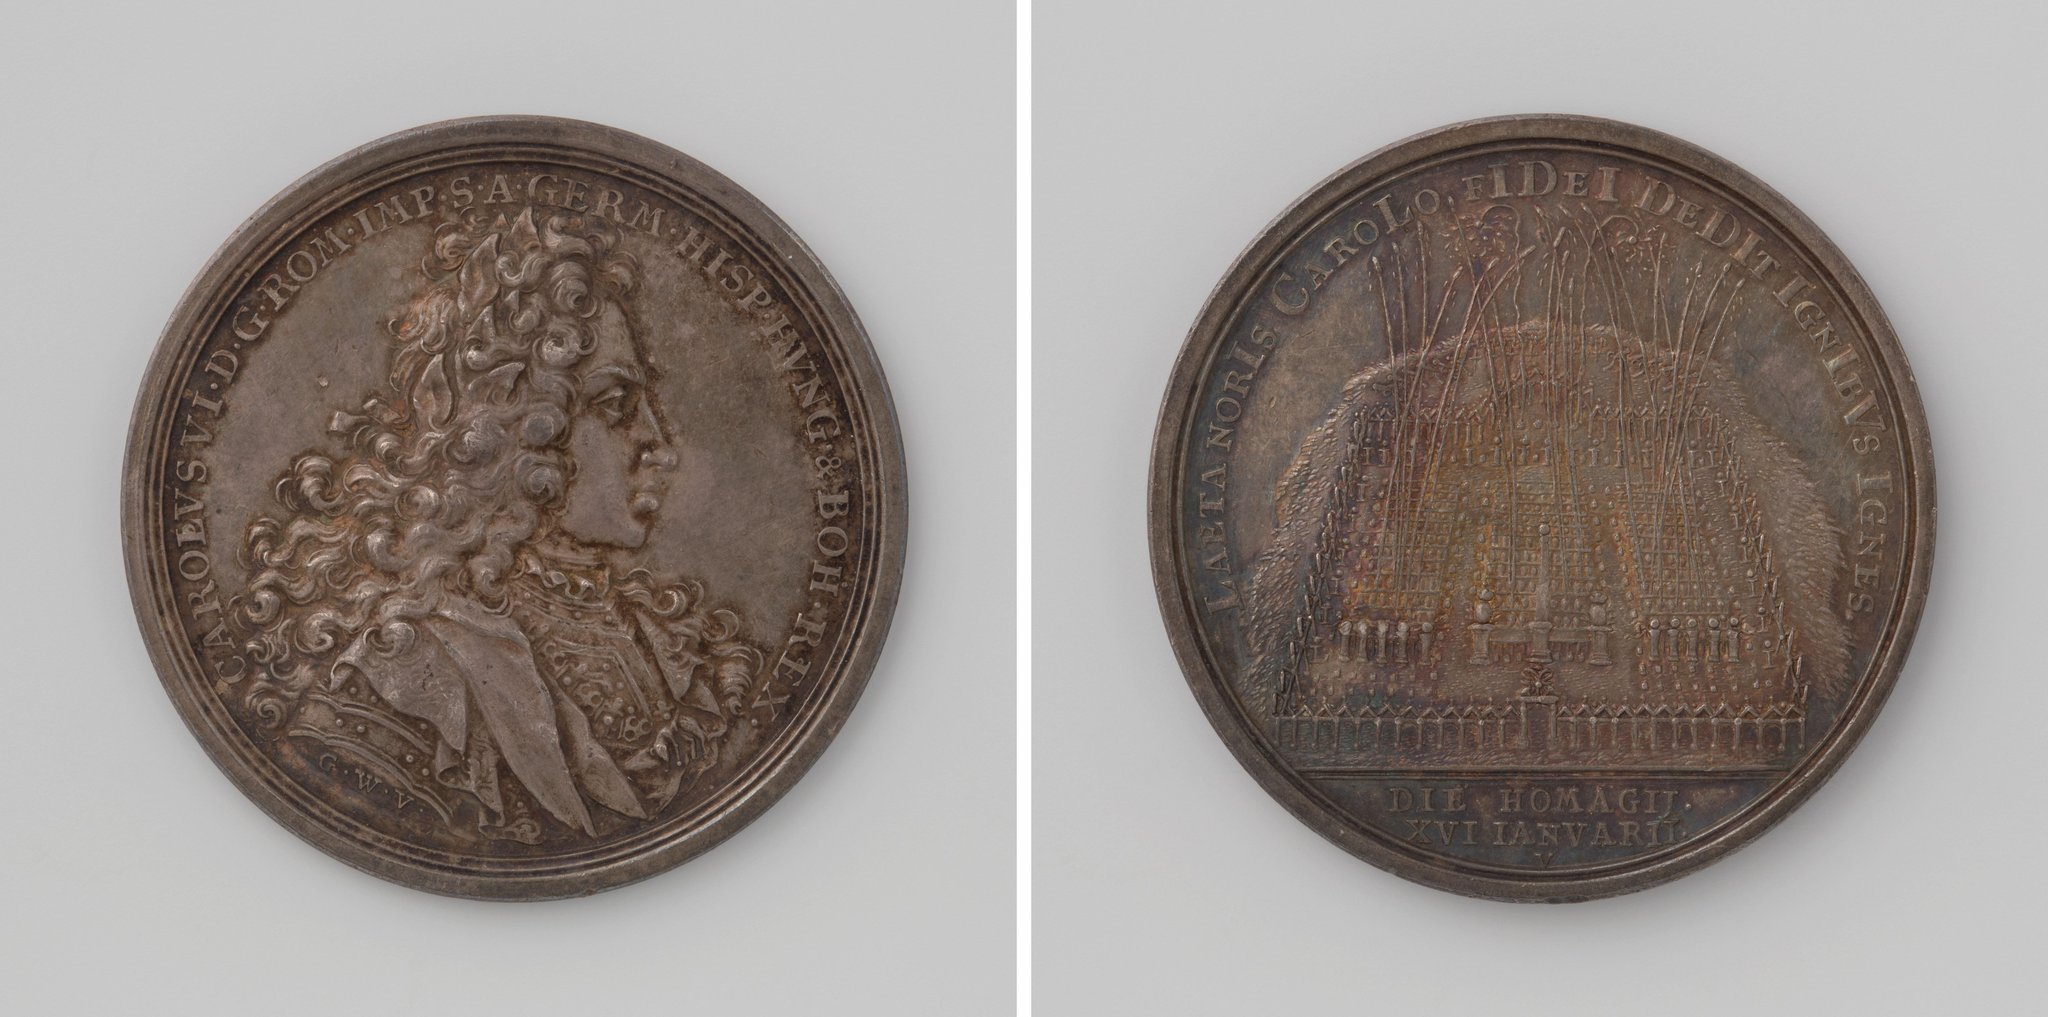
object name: history medal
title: Vuurwerk bij de kroning van Karel VI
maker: georg wilhelm vestner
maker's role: medailleur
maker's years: 1677-1740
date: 1712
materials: silver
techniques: striking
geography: nuremberg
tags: vienna, charles vi (holy roman emperor)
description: Zilveren penning. Voorzijde: borststuk man met lauwerkrans binnen omschrift. Keerzijde: vuurwerk boven paleistuin binnen omschrift; afsnede: opschrift